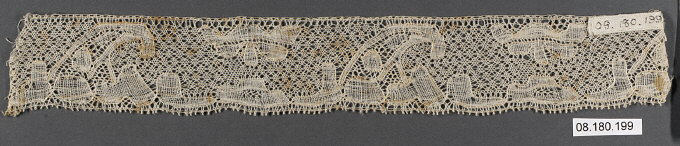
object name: fragment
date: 1801-1900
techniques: lace